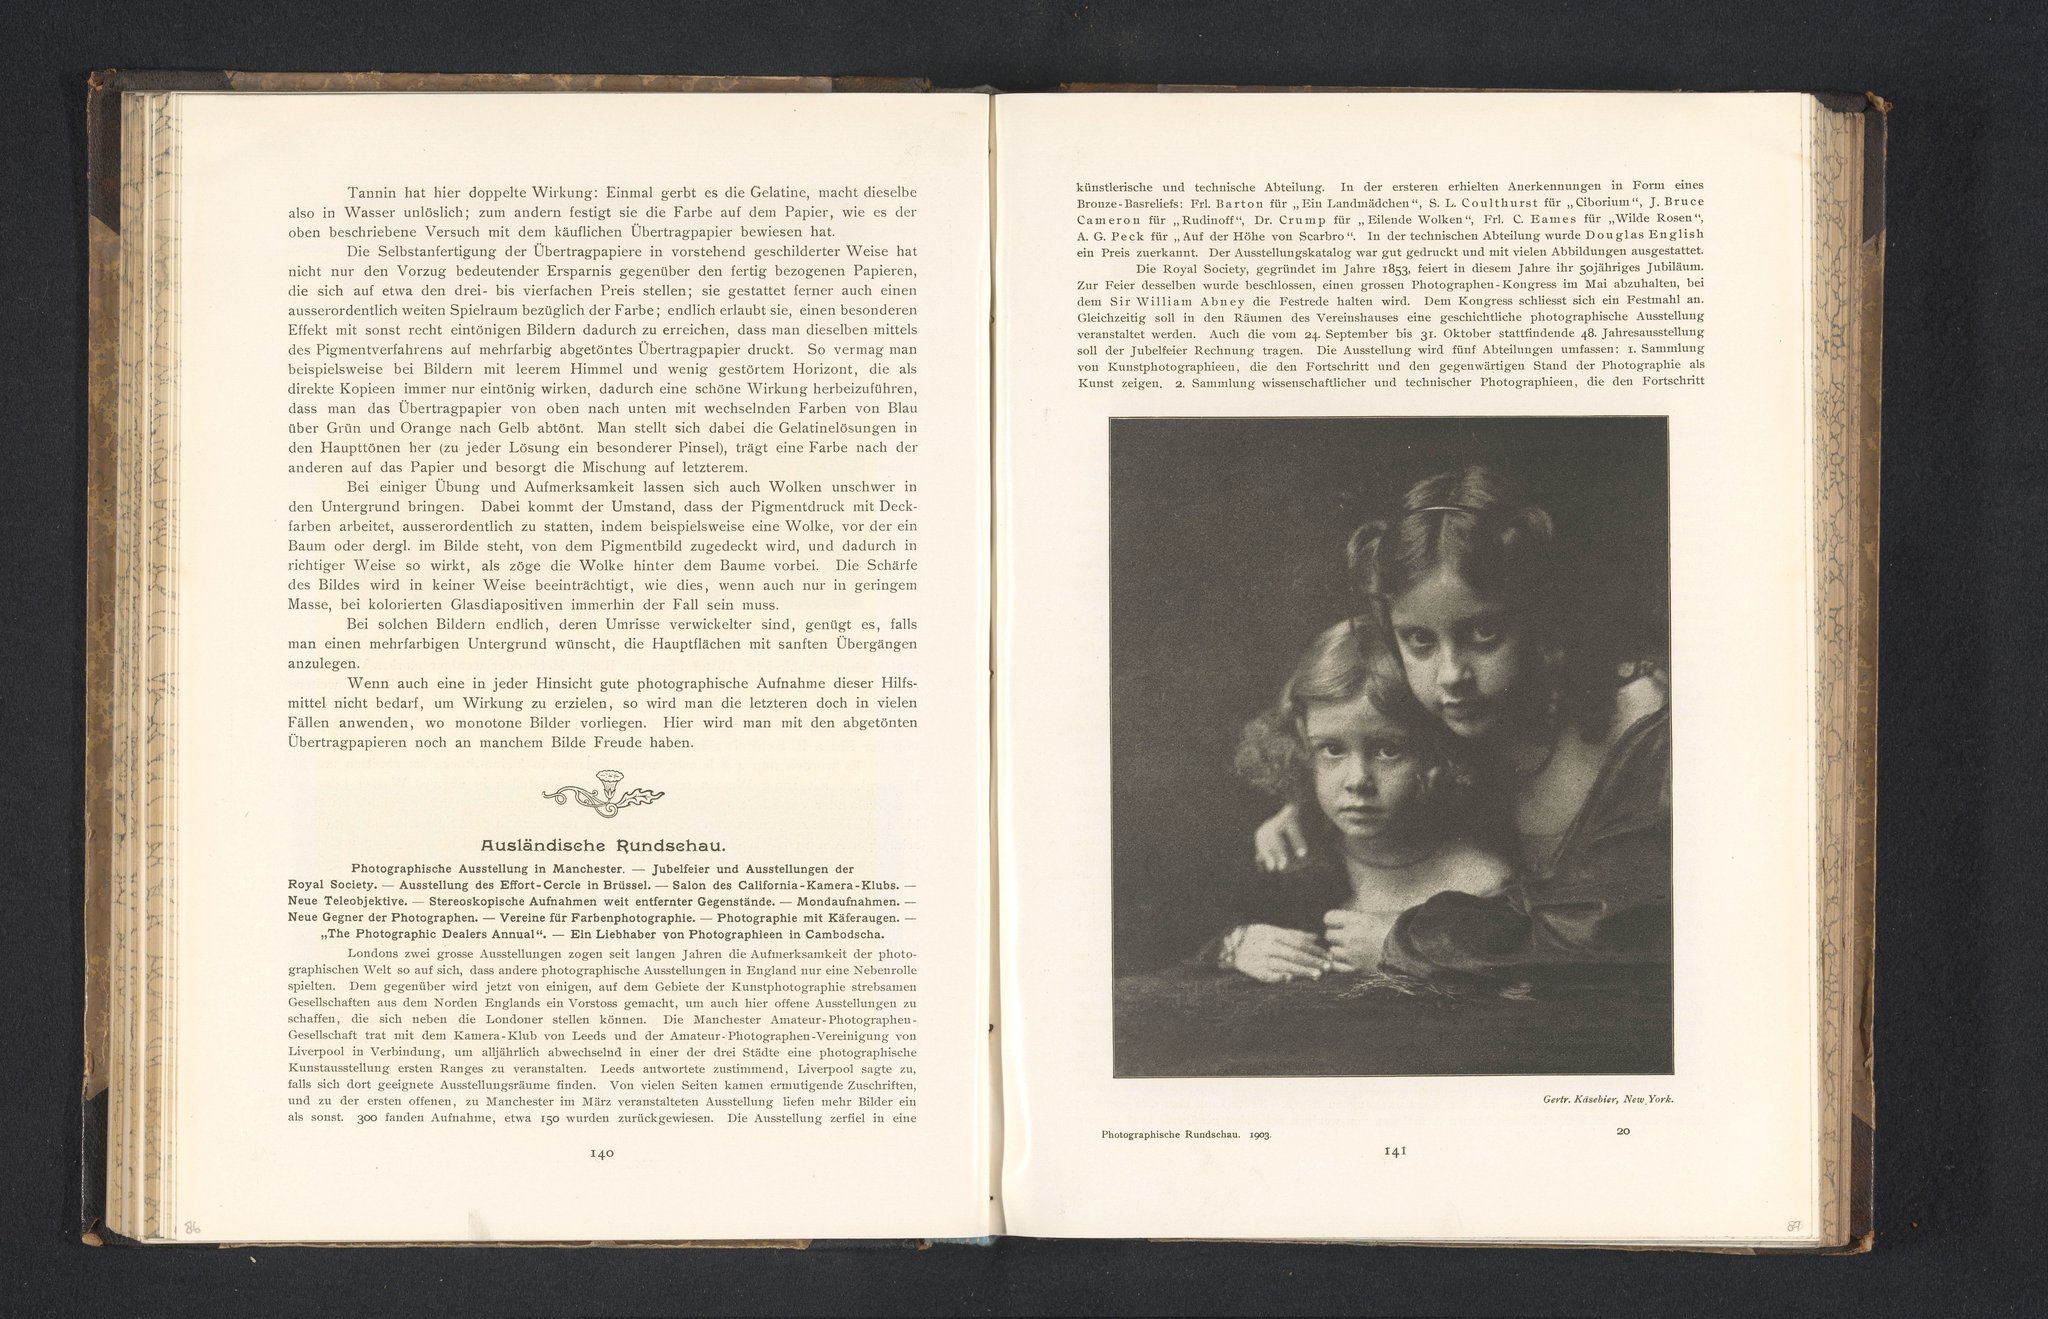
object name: page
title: Portret van twee onbekende meisjes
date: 1898-1903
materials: paper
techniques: autotype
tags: anonymous historical persons portrayed in a double portrait - bb - woman, girl (child between toddler and youth)